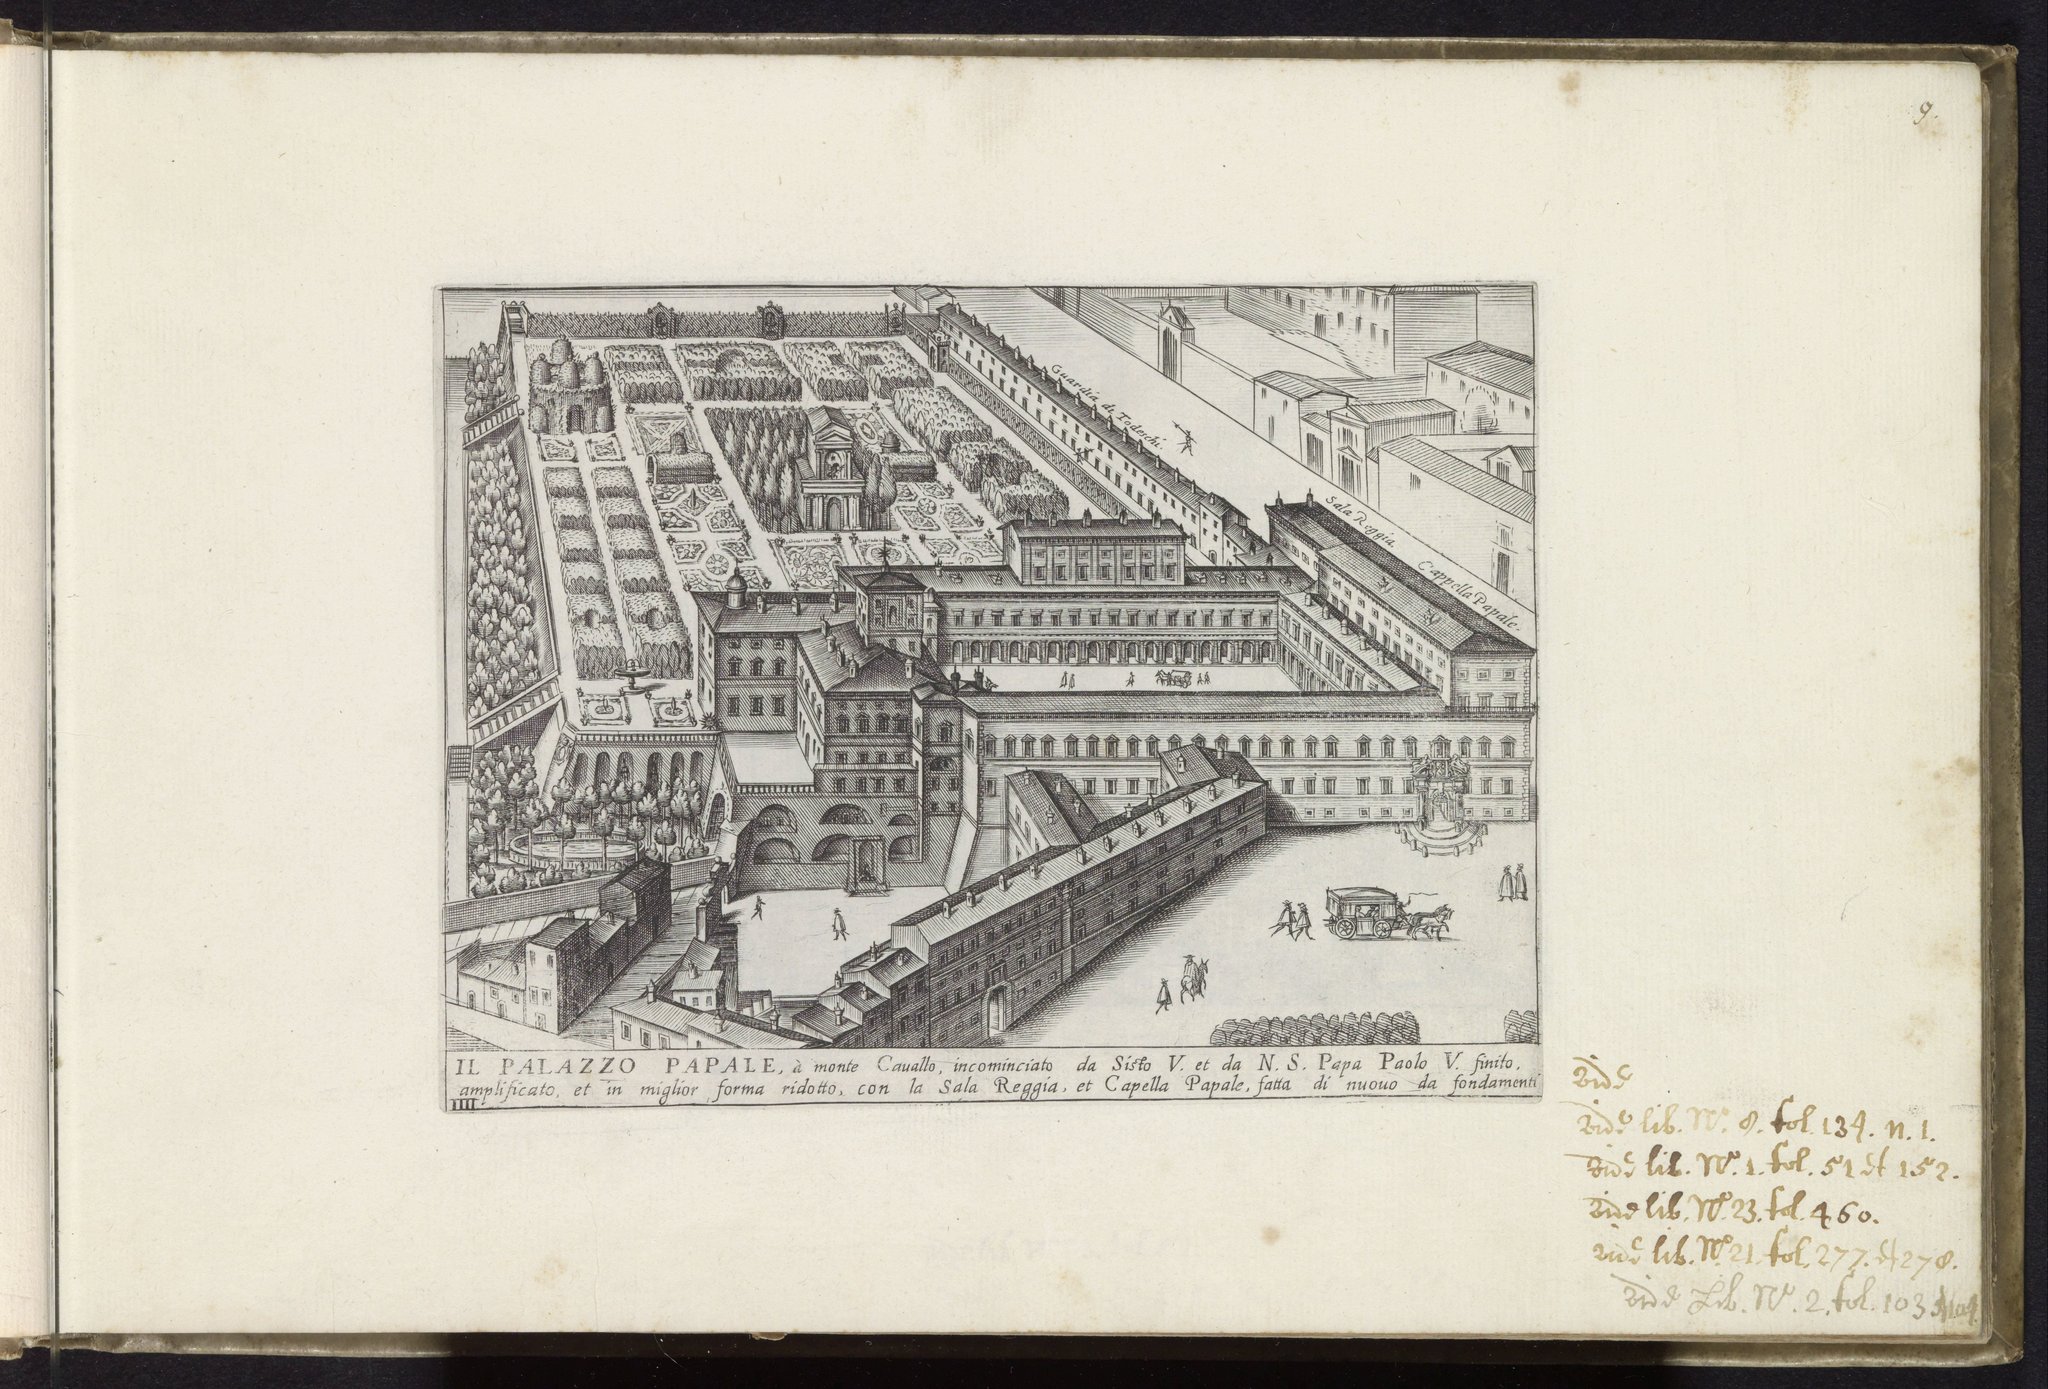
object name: print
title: Il Palazzo Papale, à monte Cavallo, incominciato da Sisto V. et da N. S. Papa Paolo V (...)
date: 1618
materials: paper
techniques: engraving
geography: rome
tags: garden, palace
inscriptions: inscription: ‘Ende/ Ende lib. No. 8. fol. 134. n. 1./ Ende lib. No. 2. fol. 52 et 152...’, number: ‘9’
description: Deze prent maakt deel uit van een reeks van twaalf prenten met monumenten en gebouwen opgericht tijdens de pontificaten van paus Paulus V en Sixtus V.